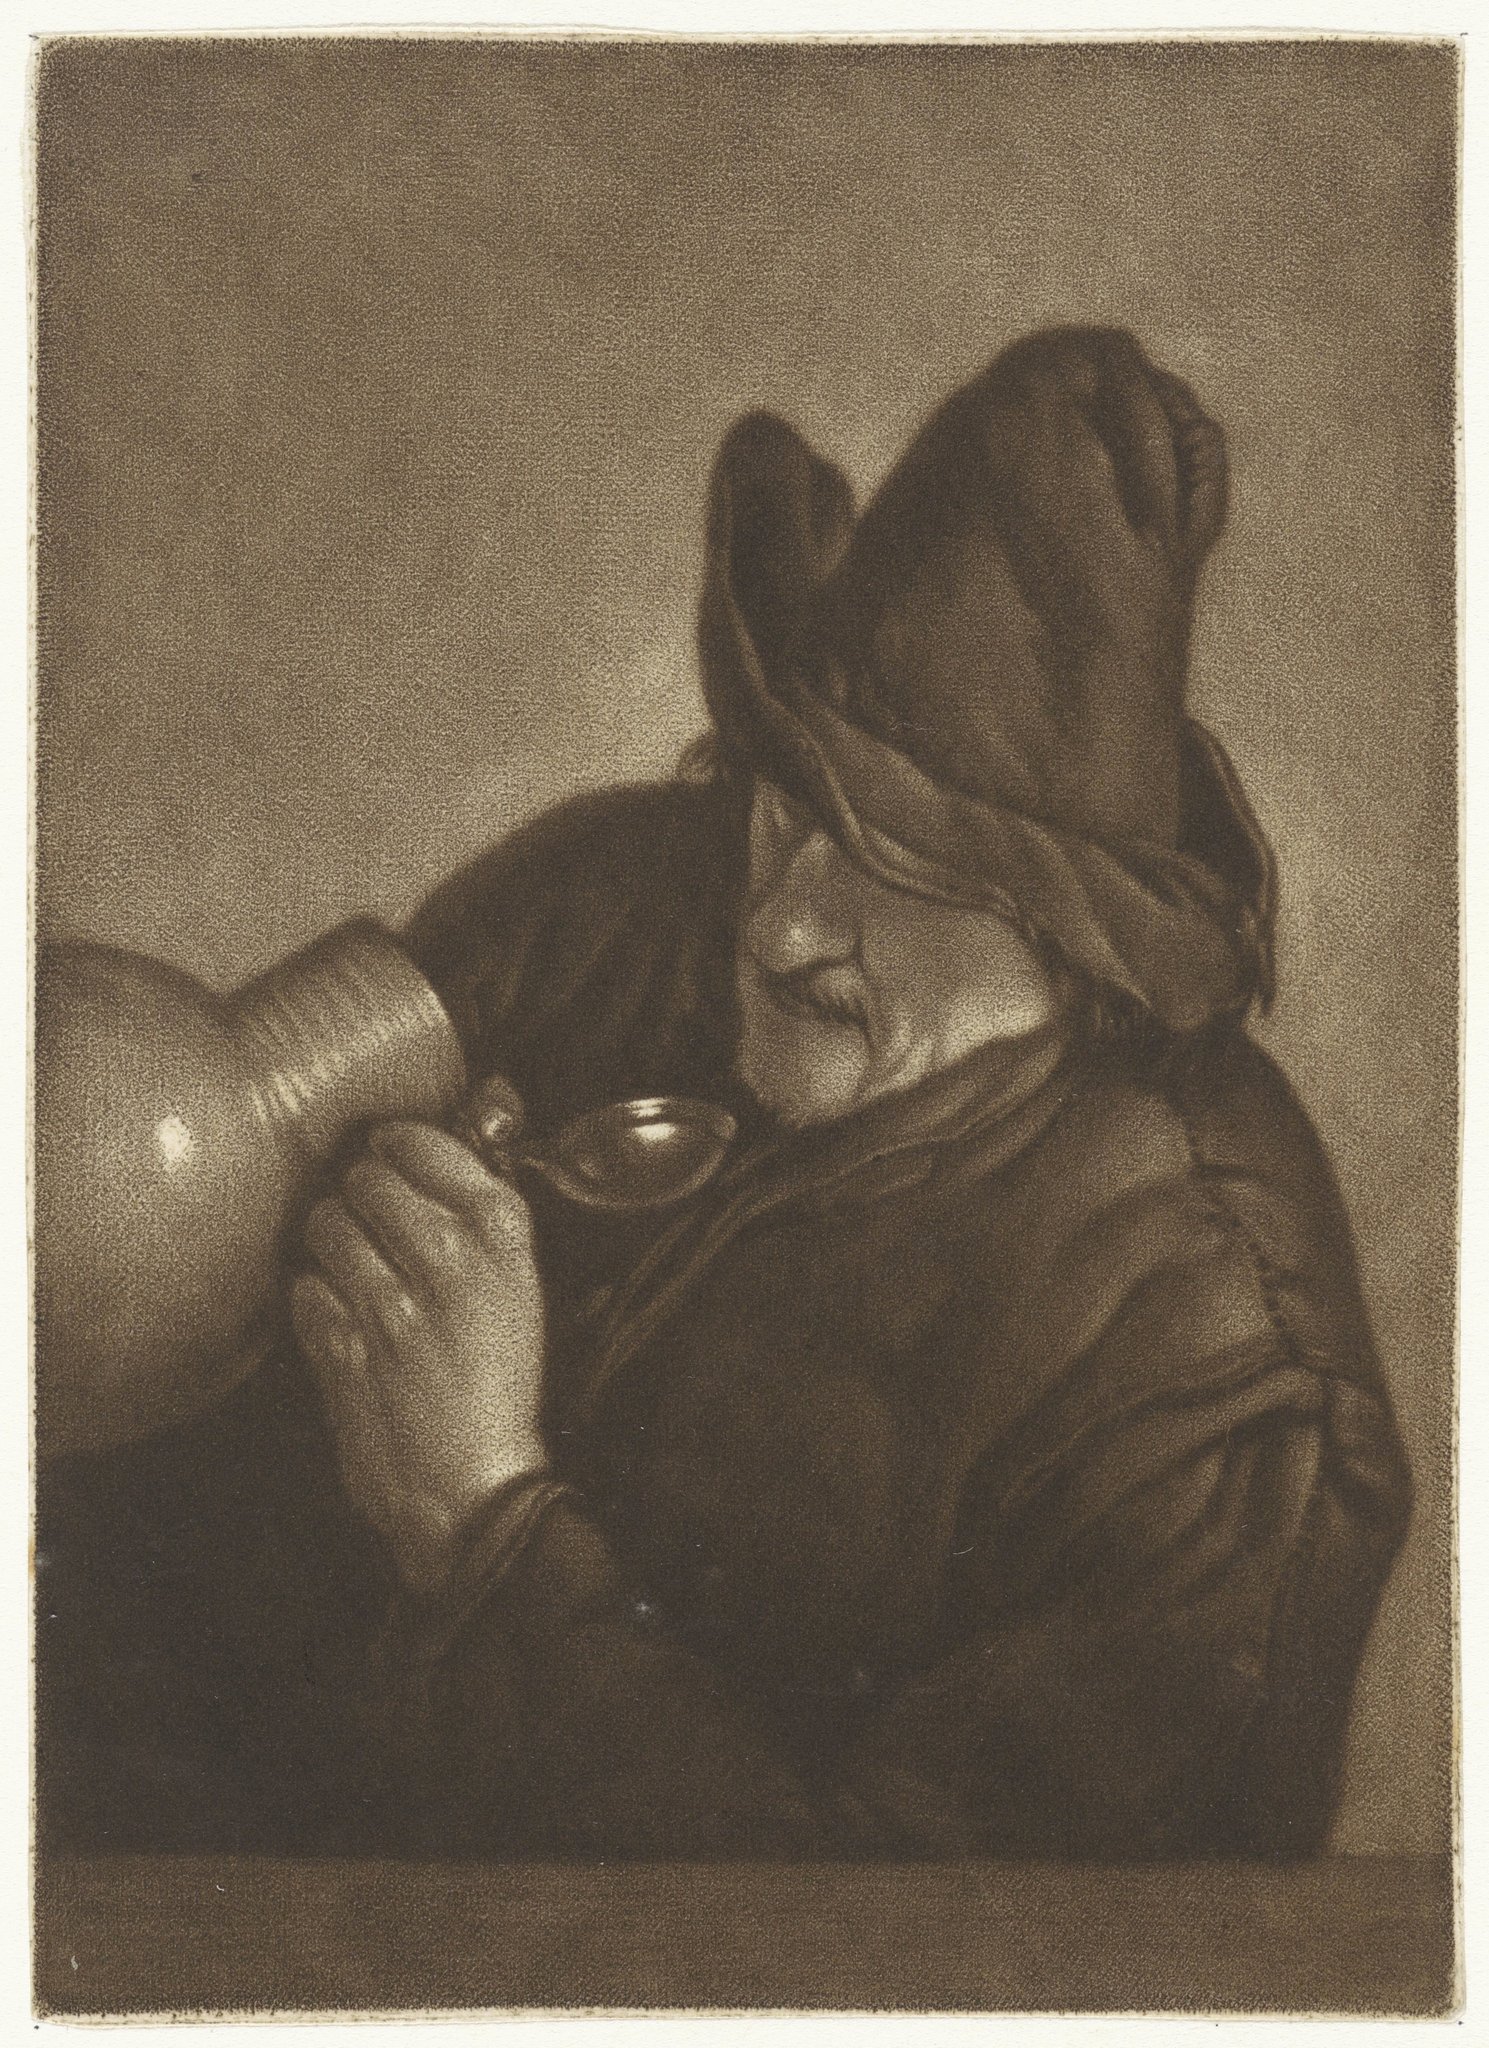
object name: print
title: Man kijkt in een lege kruik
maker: jan stolker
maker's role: draughtsman, painter, print maker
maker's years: 1724-1785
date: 1734-1785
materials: paper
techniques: mezzotint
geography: northern netherlands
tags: jar, jug (used as drinking-vessel), head-gear: hat (+ men's clothes)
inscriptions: collector's mark: Lugt 240